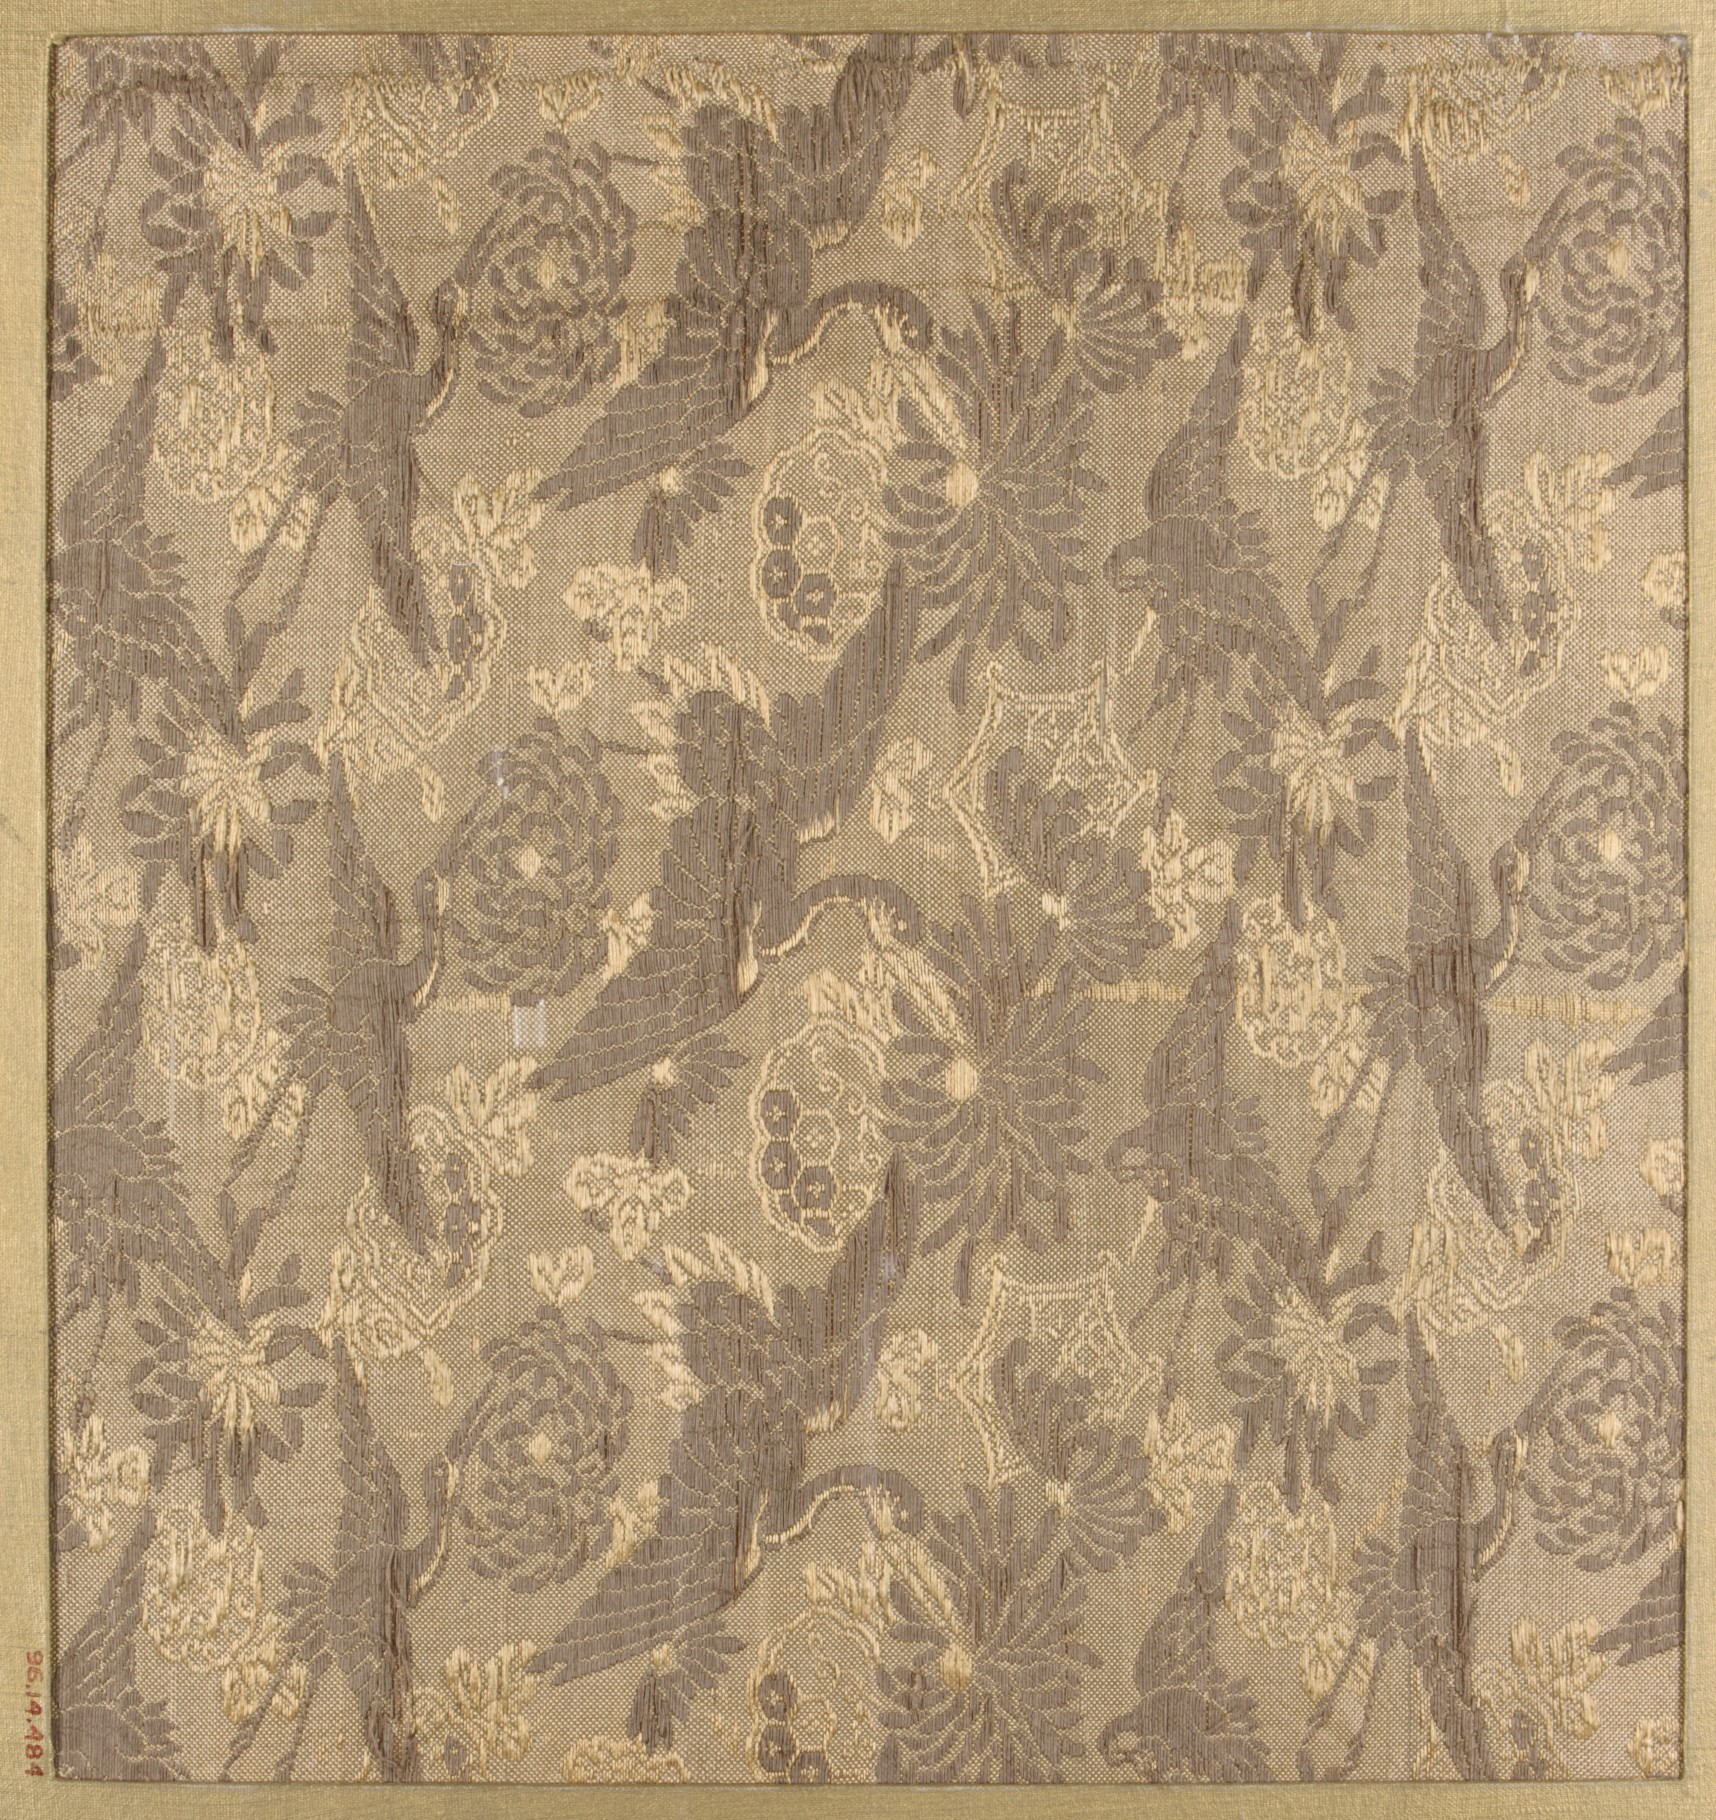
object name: fragment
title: Textile fragment with repeating pattern of cranes and chrysanthemums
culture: japanese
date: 1701-1900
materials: silk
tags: flowers